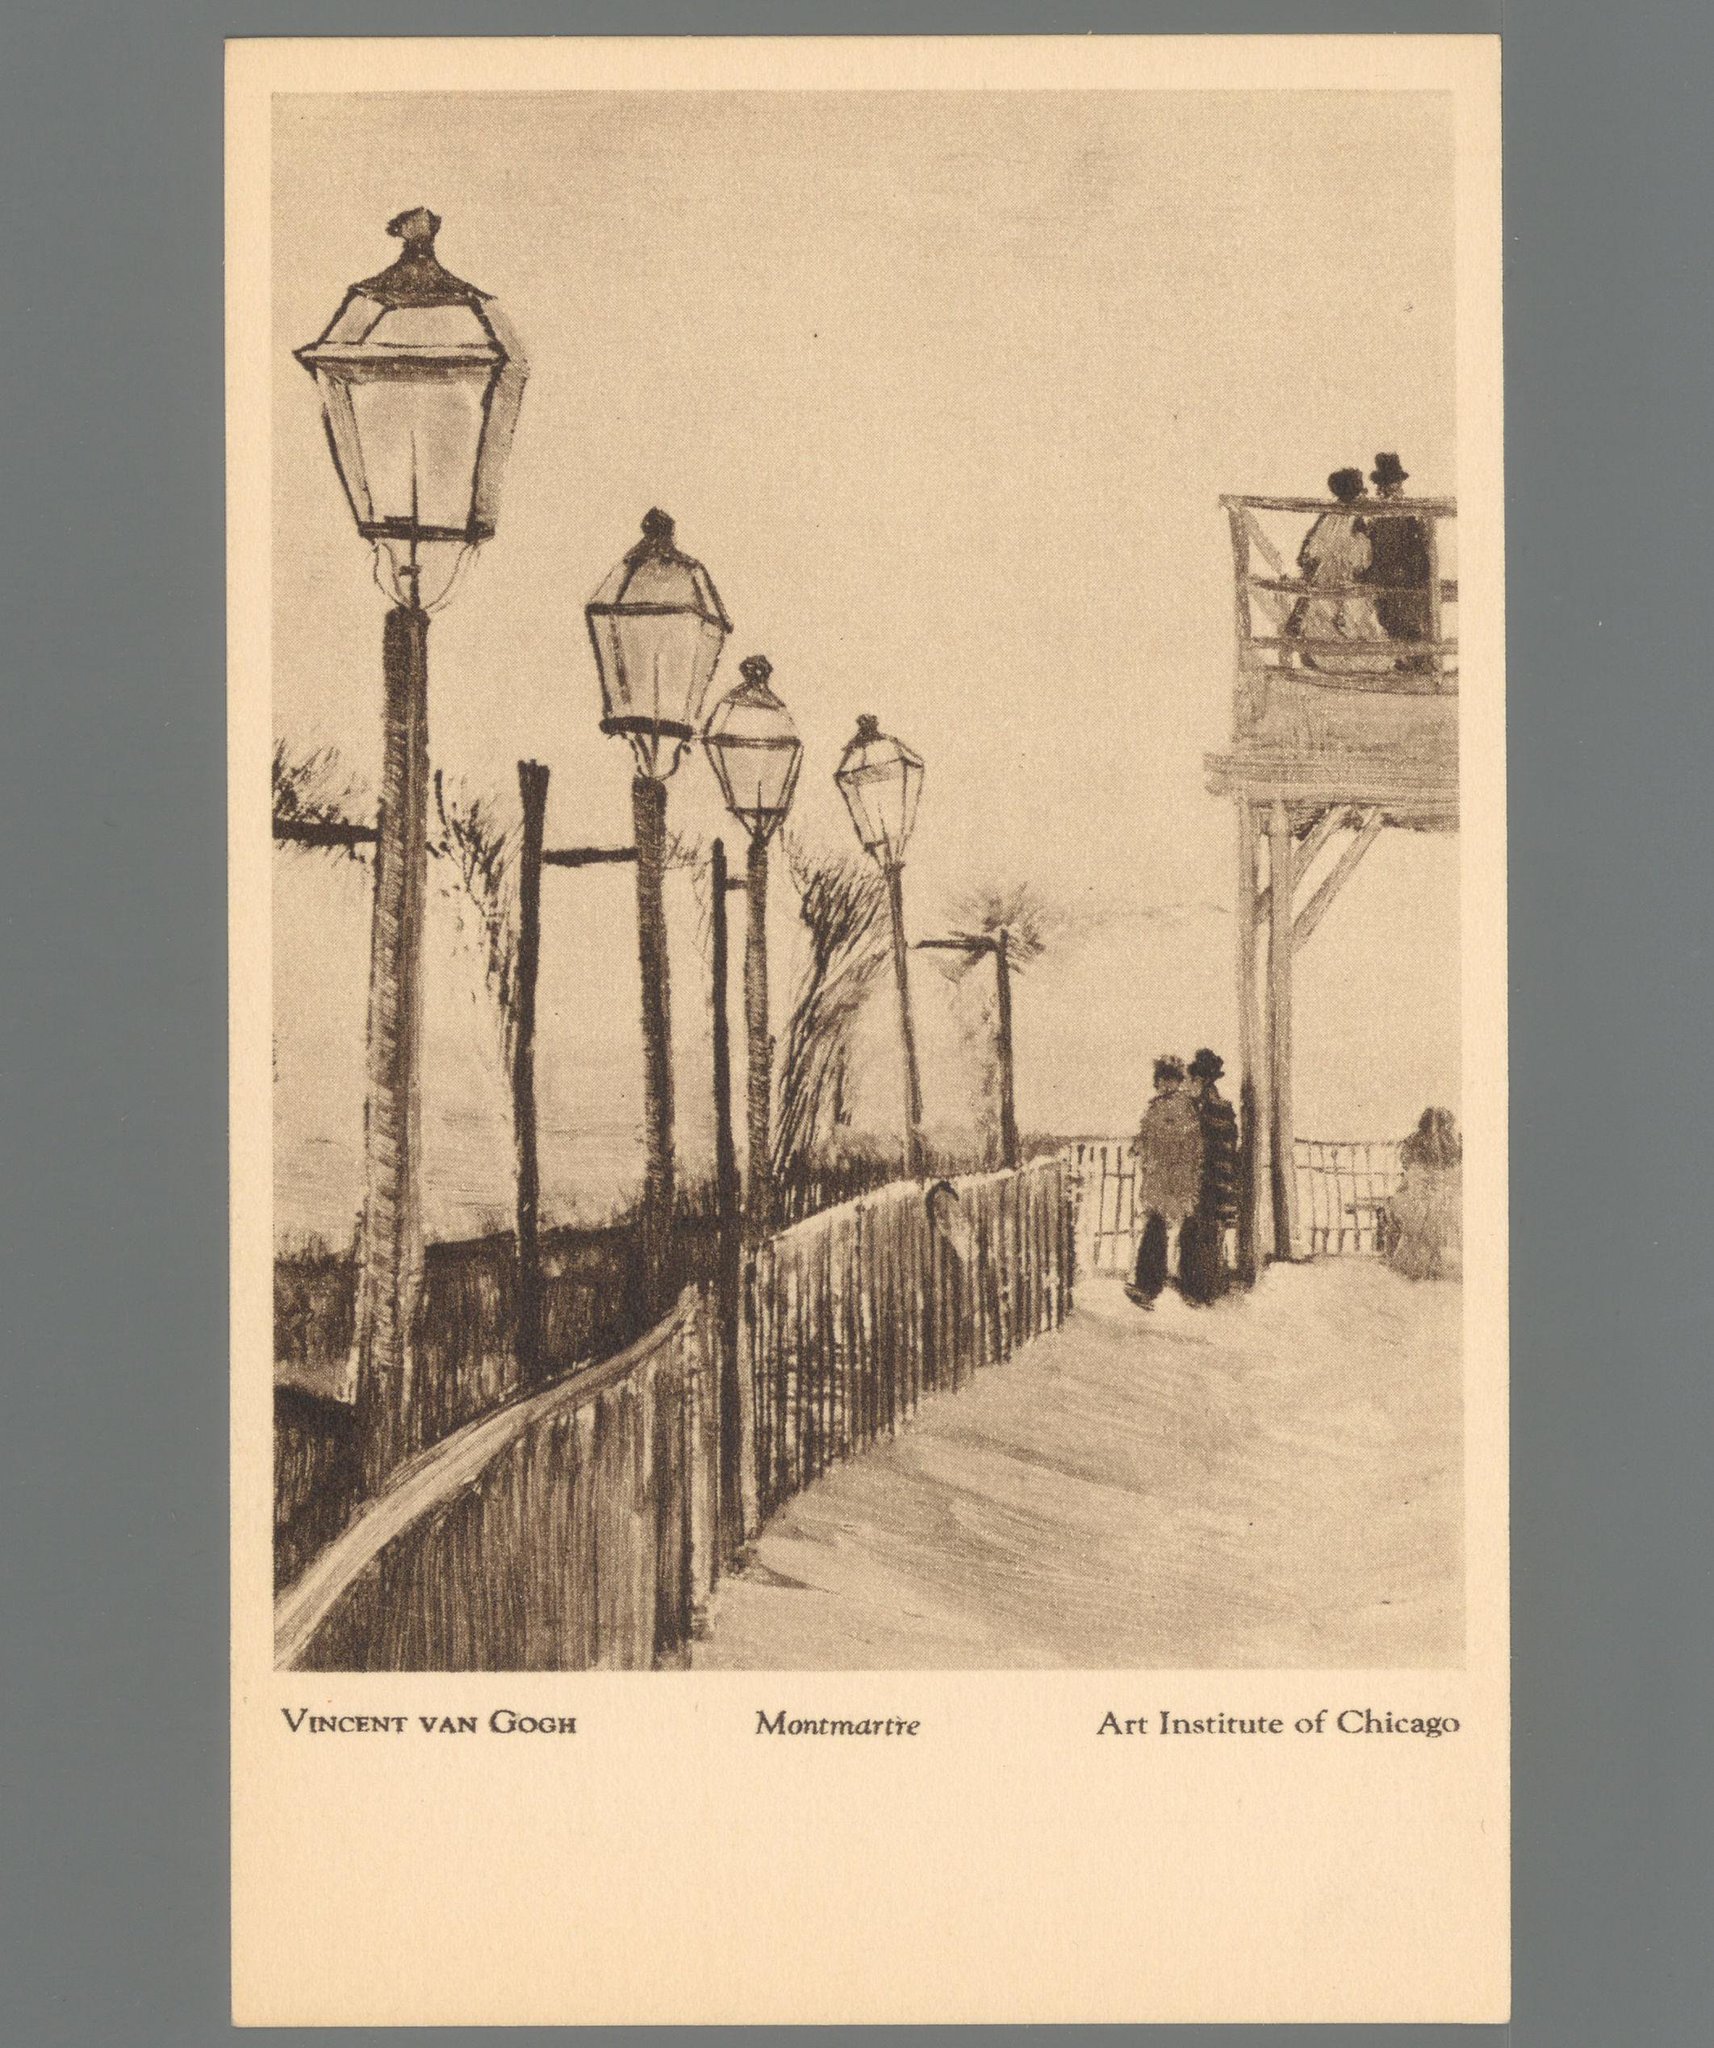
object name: photomechanical print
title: Montmartre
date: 1926-1945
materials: cardboard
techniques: rotogravure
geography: chicago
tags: gas-lamp, public gardens, park (+ city(-scape) with figures, staffage)